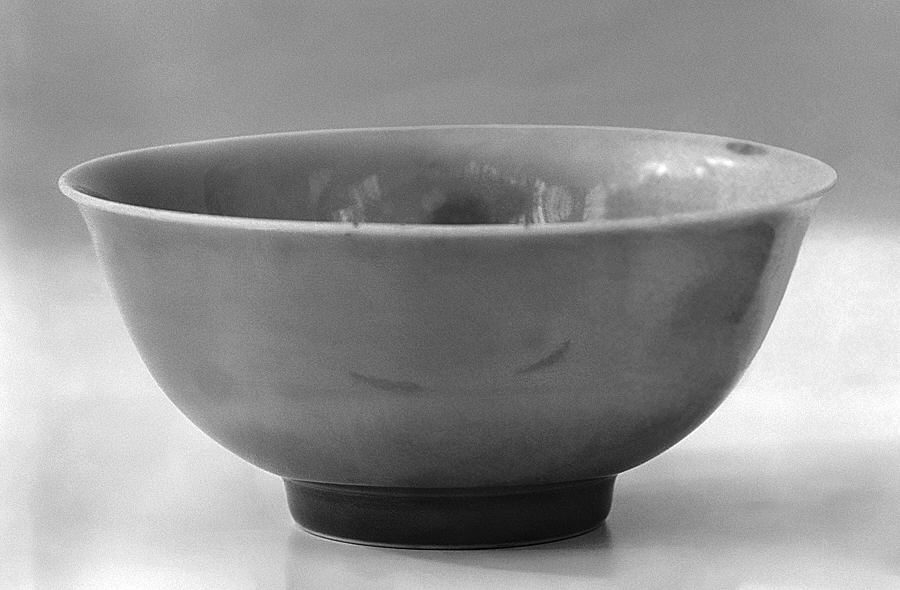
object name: bowl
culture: chinese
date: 1662-1722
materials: glaze, porcelain